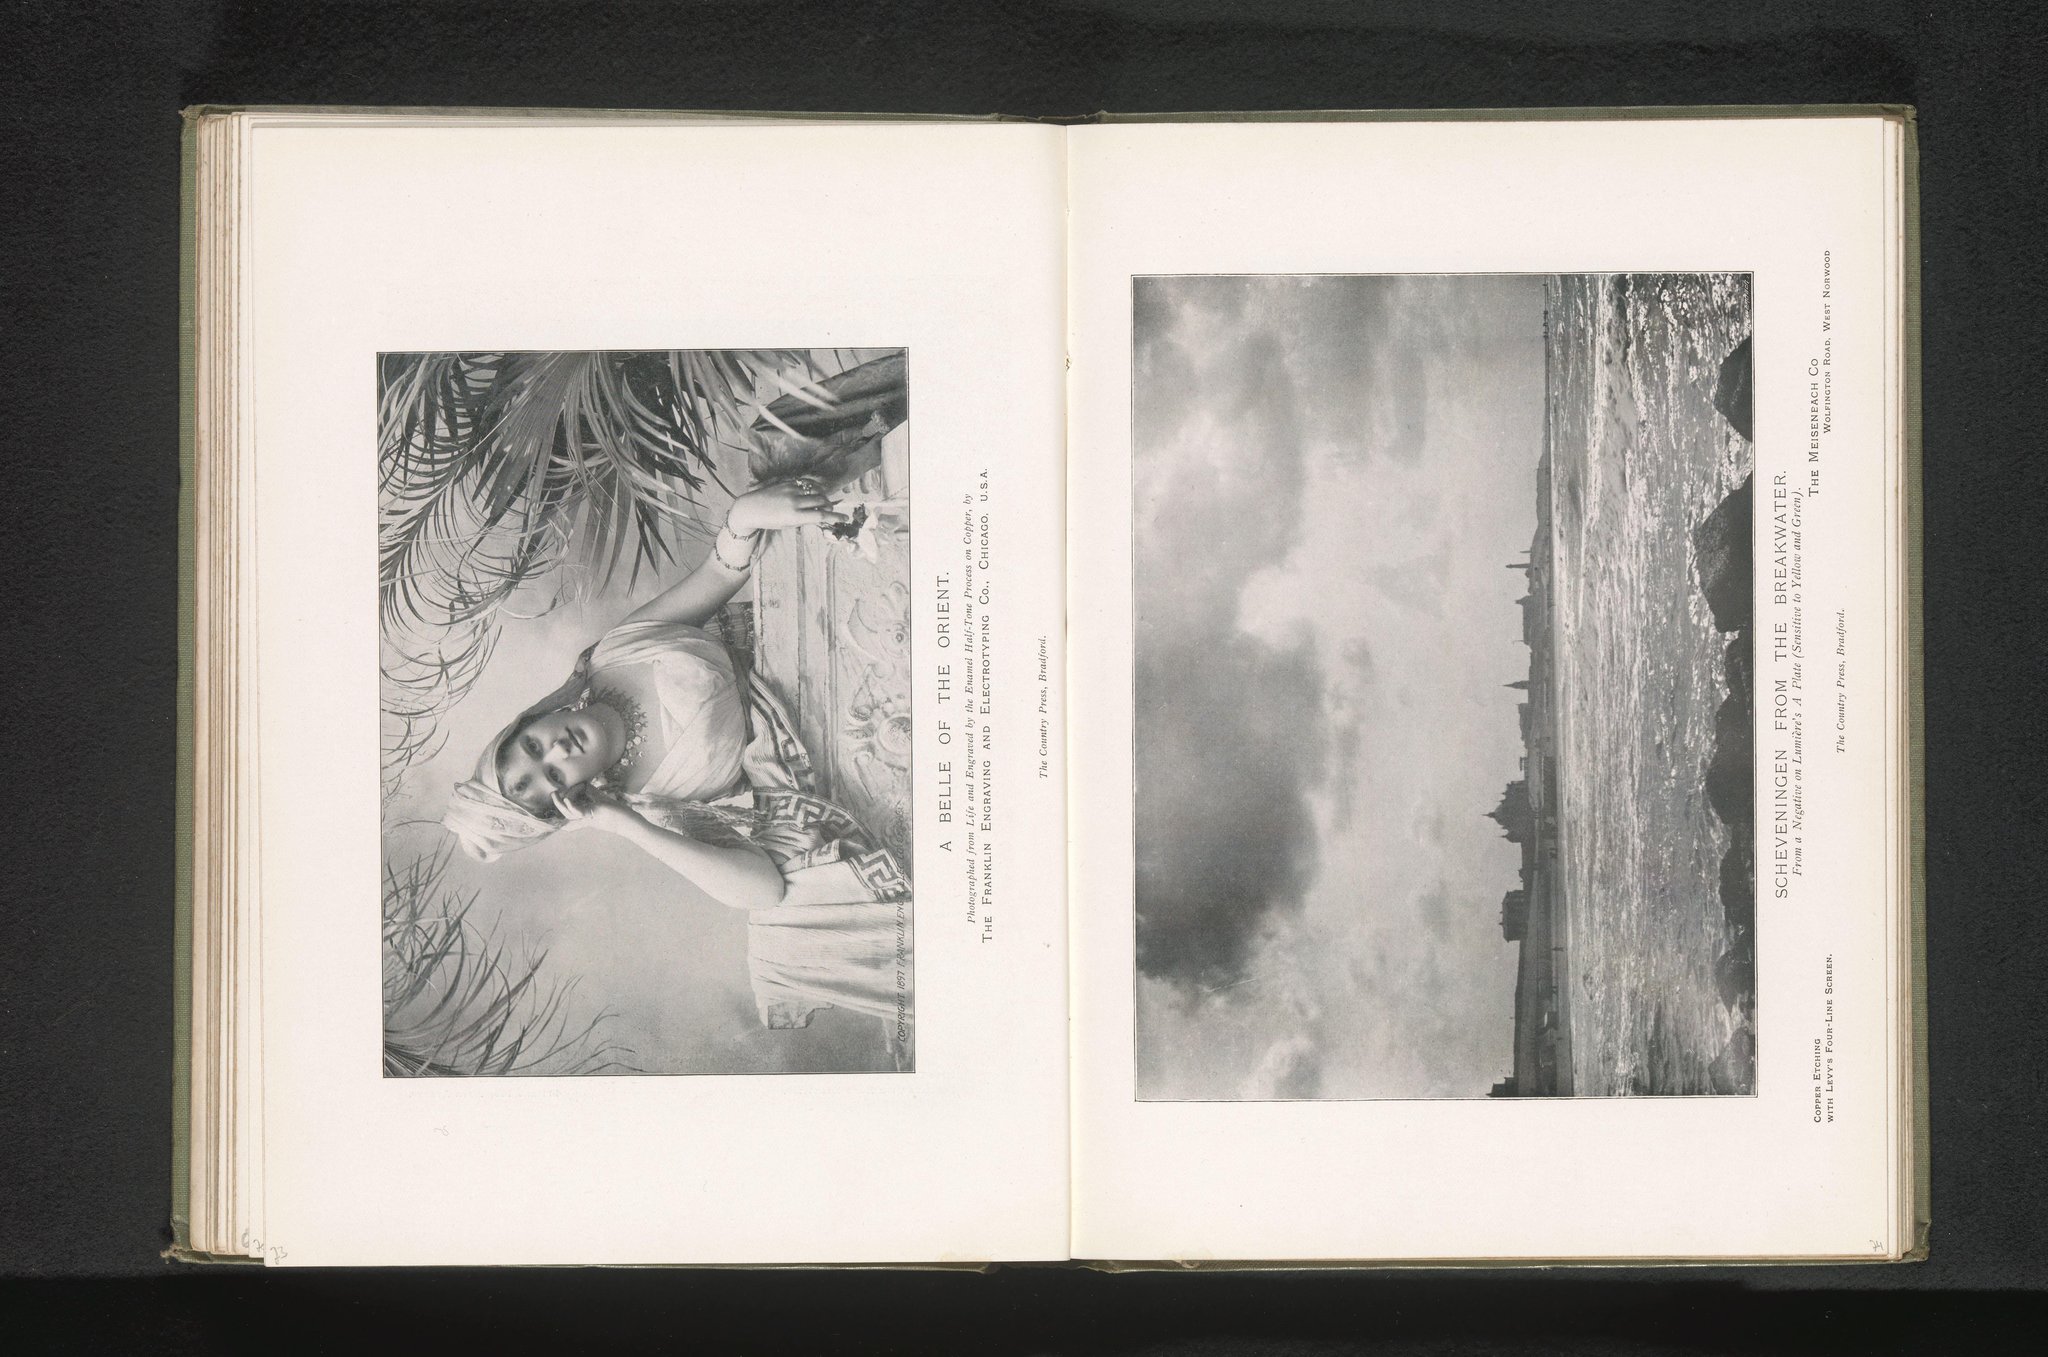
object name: page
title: Scheveningen from the breakwater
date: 1893-1898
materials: paper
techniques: autotype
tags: city-view in general; 'veduta', landscapes with waters, waterscapes, seascapes (in the temperate zone)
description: Prent op derde ongenummerde pagina na pagina 92.